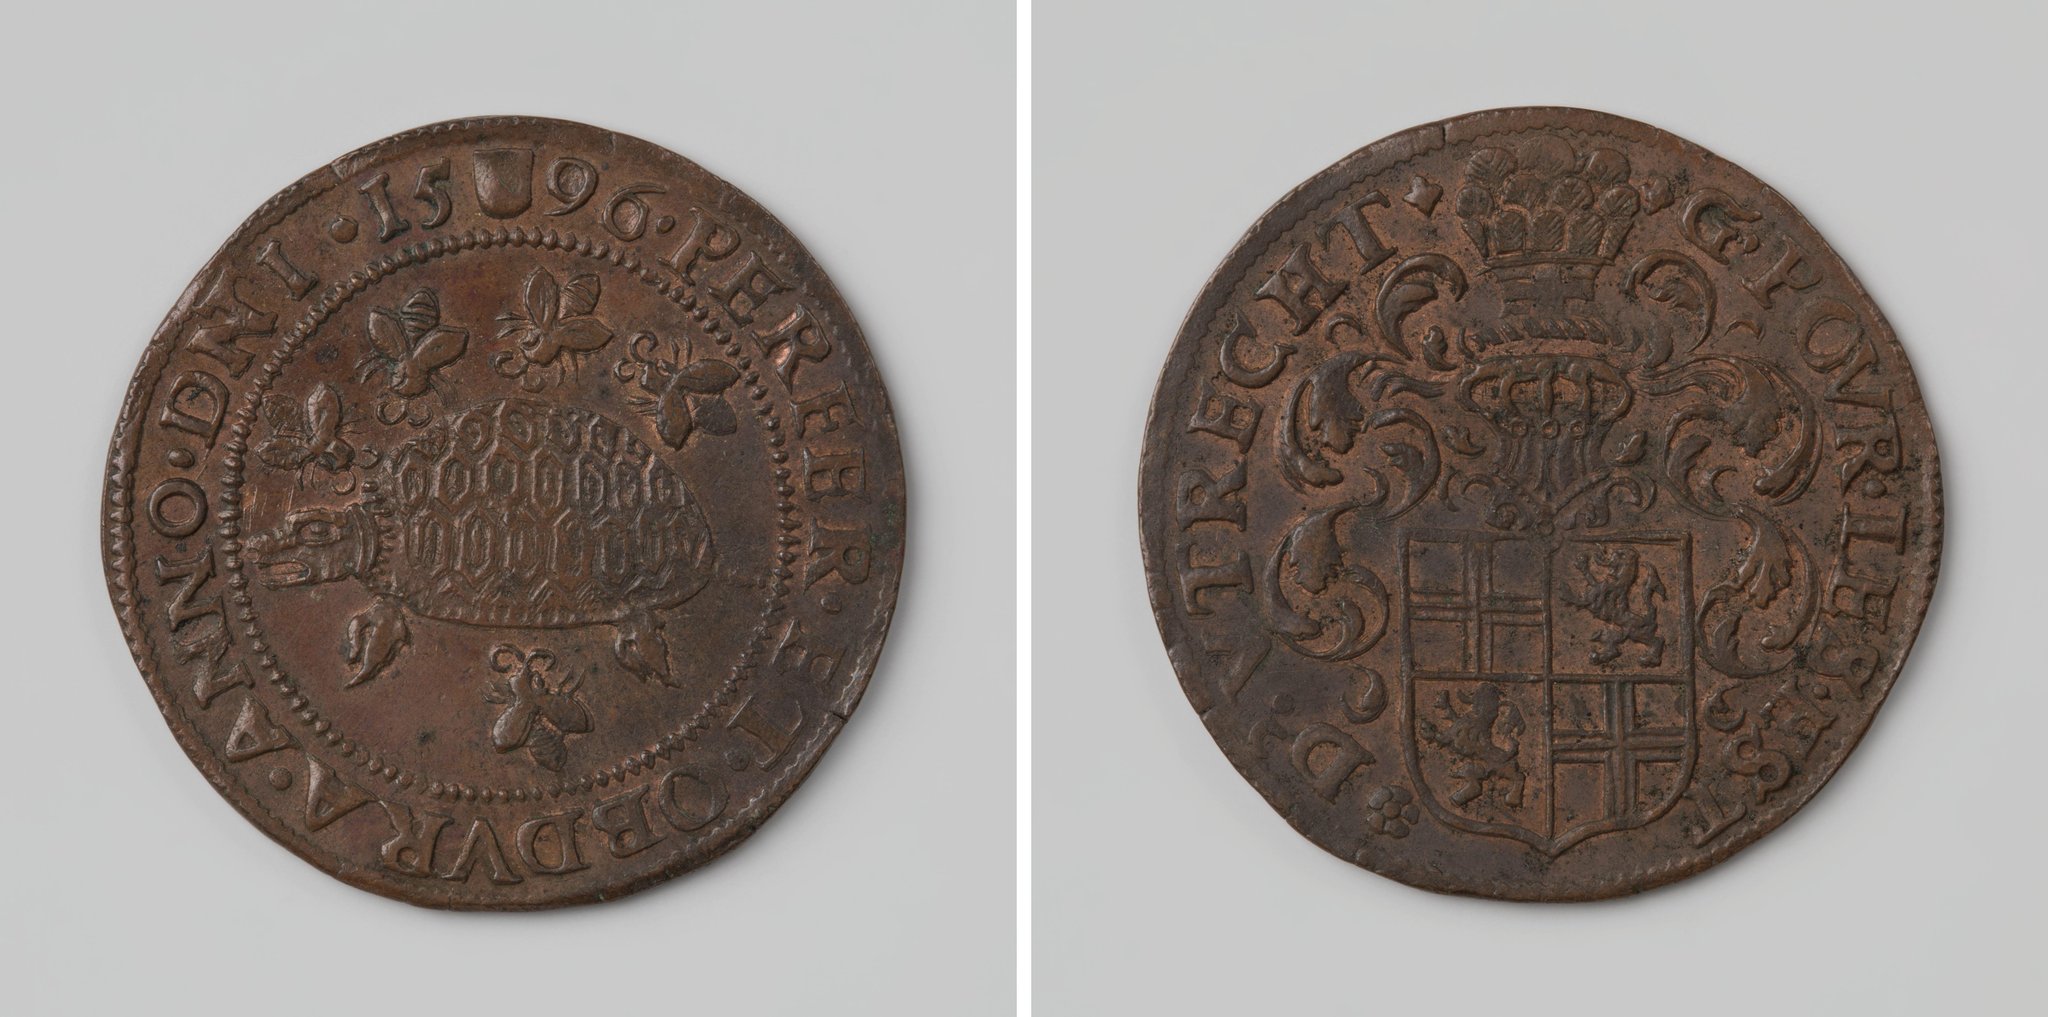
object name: jeton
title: Oproep om de druk der verhoogde belastingen geduldig te dragen, rekenpenning van de Staten van Utrecht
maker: Anonymous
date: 1596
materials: copper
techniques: striking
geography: utrecht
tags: utrecht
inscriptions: circumscription: ‘PERFER ET OBDVRA ANNO DNI 1596’, circumscription: ‘G POVR LES EST D VTRECHT’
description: Koperen penning. Voorzijde: schildpad, die door vijf bijen wordt aangevallen binnen omschrift. Keerzijde: gehelmd wapenschild onder korf met veren binnen omschrift.